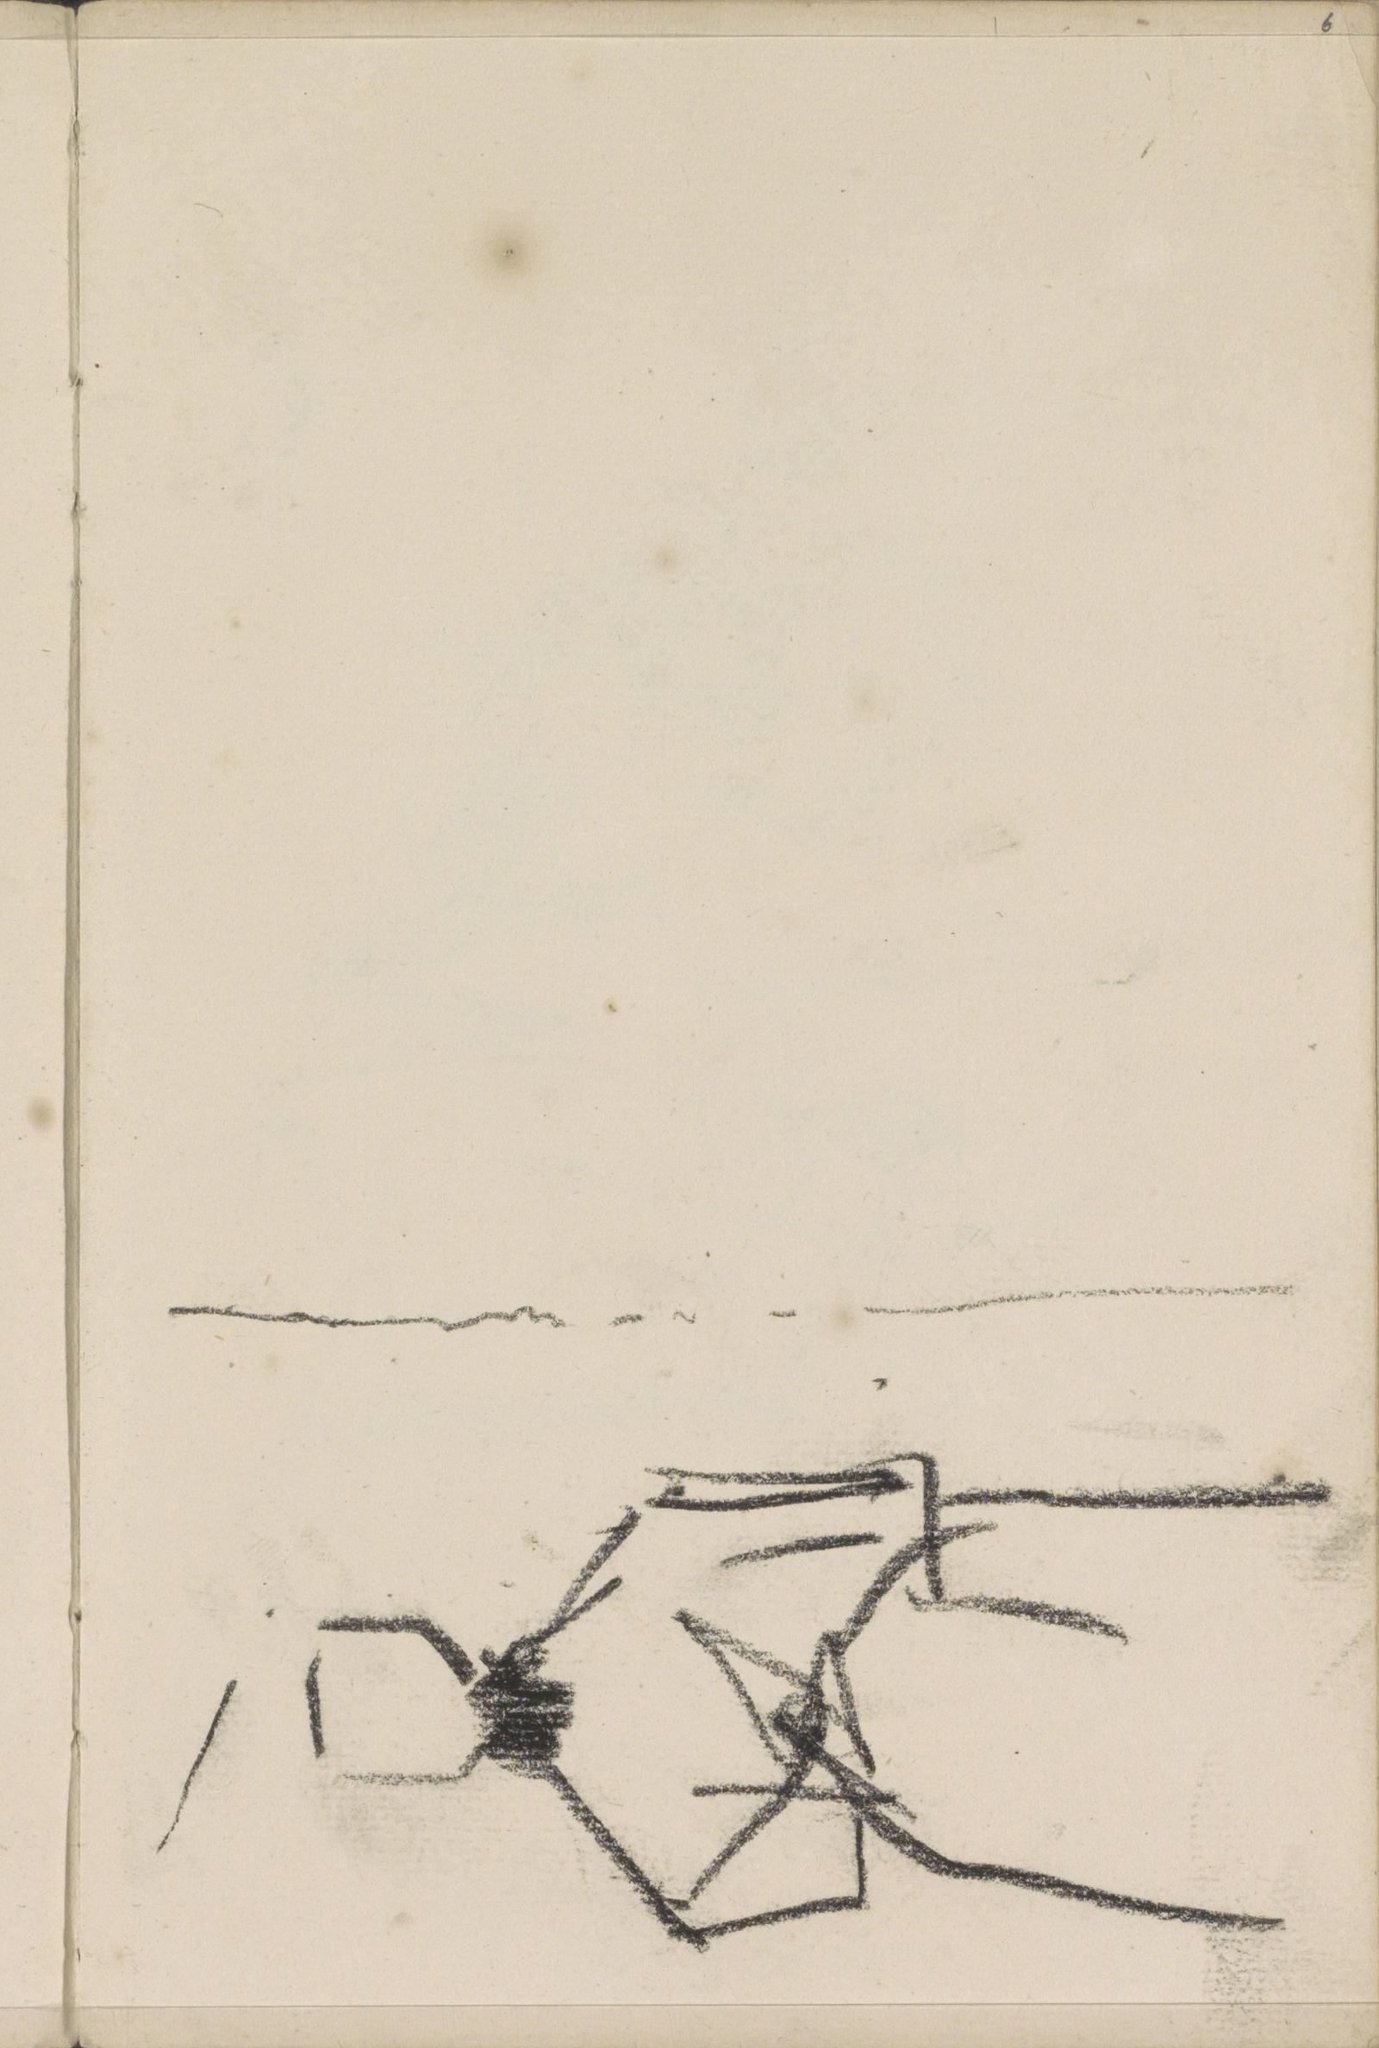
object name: sketchbook leaf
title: Staande vrouw, op de rug gezien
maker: george hendrik breitner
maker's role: draughtsman, painter, print maker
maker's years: 1857-1923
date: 1883-1885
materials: chalk, paper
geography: the hague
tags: adult woman, standing figure - aa - female human figure (+ back view)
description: Pagina 6 uit een schetsboek met 18 bladen.